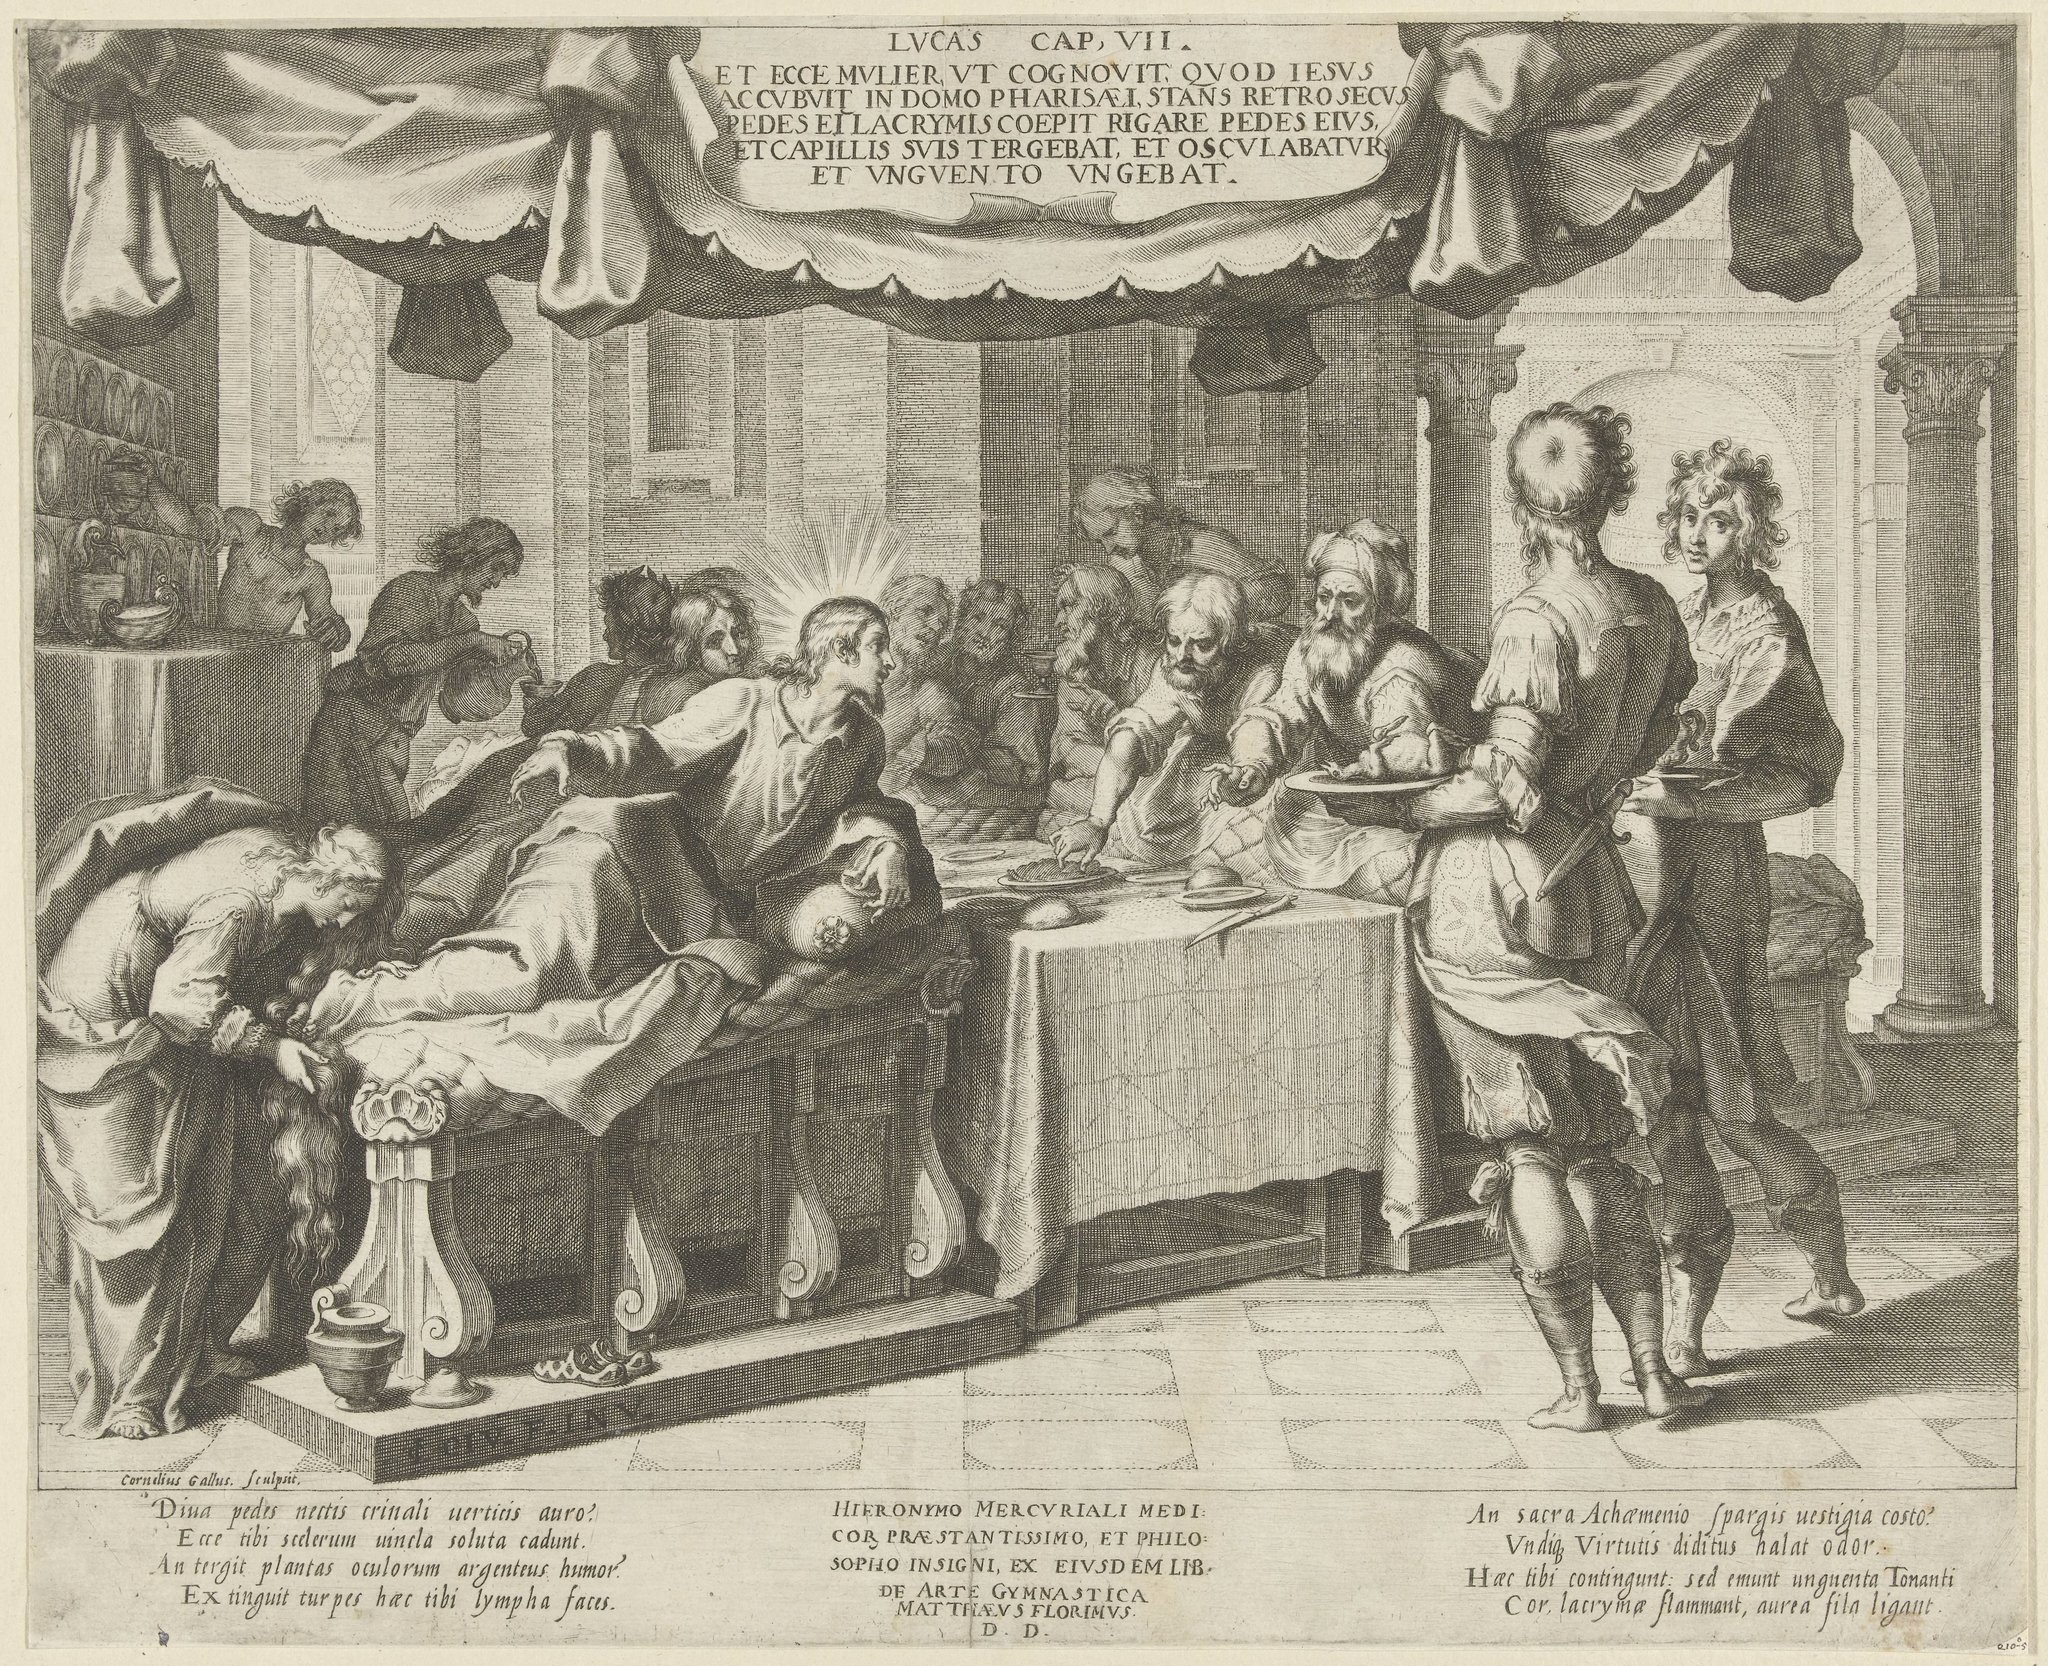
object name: print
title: Christus te gast bij Simon de Farizeeër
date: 1590-1610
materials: paper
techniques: engraving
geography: italy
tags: a woman washes christ's feet with her tears, and wipes them with her hair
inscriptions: collector's mark: Lugt 240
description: Christus is te gast in het huis van Simon de Farizeeër. Hij ligt aan tafel terwijl Maria Magdalena zijn voeten zalft en met haar haar droogt. Twee bedienden staan voor de tafel en brengen schalen met gebraden gevogelte. Onder de voorstelling een vers in het Latijn.